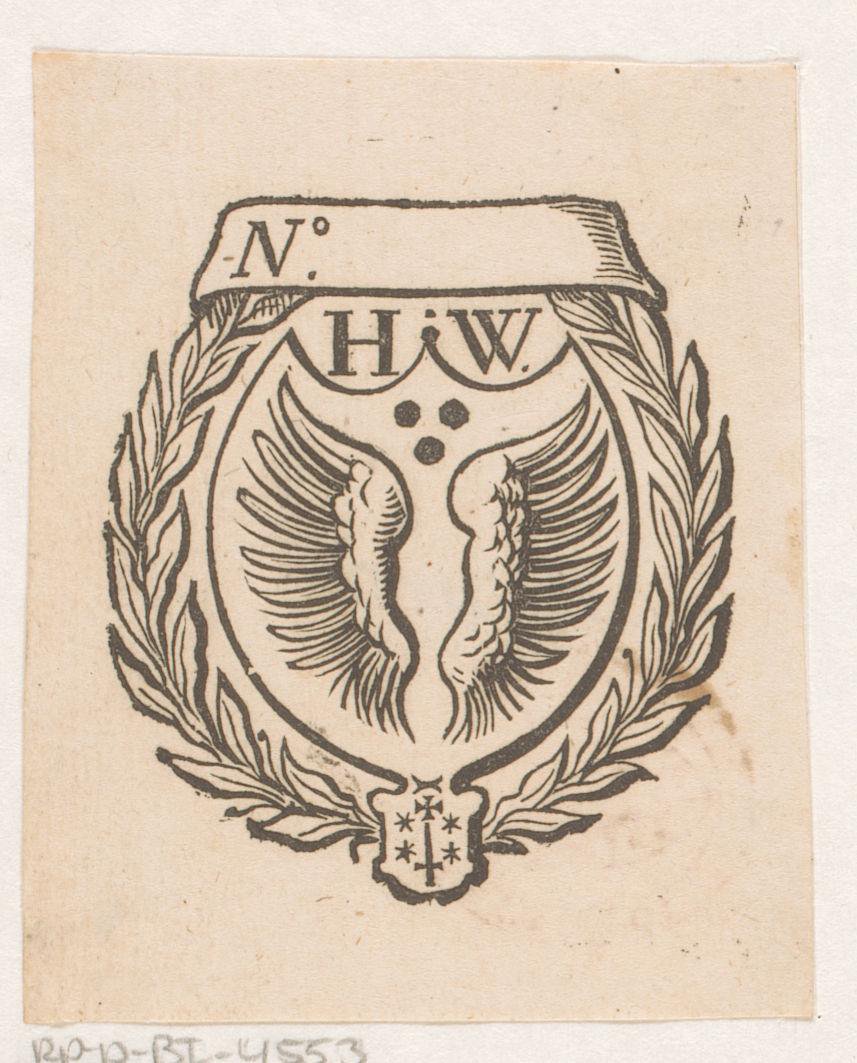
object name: print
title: Vignet met twee vleugels, het monogram HW en het wapen van de stad Haarlem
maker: Anonymous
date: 1600-1699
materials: paper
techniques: woodcut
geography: netherlands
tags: coat of arms (as symbol of the state, etc.) (+ city; municipal), vignette, haarlem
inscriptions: collector's mark: Lugt 240